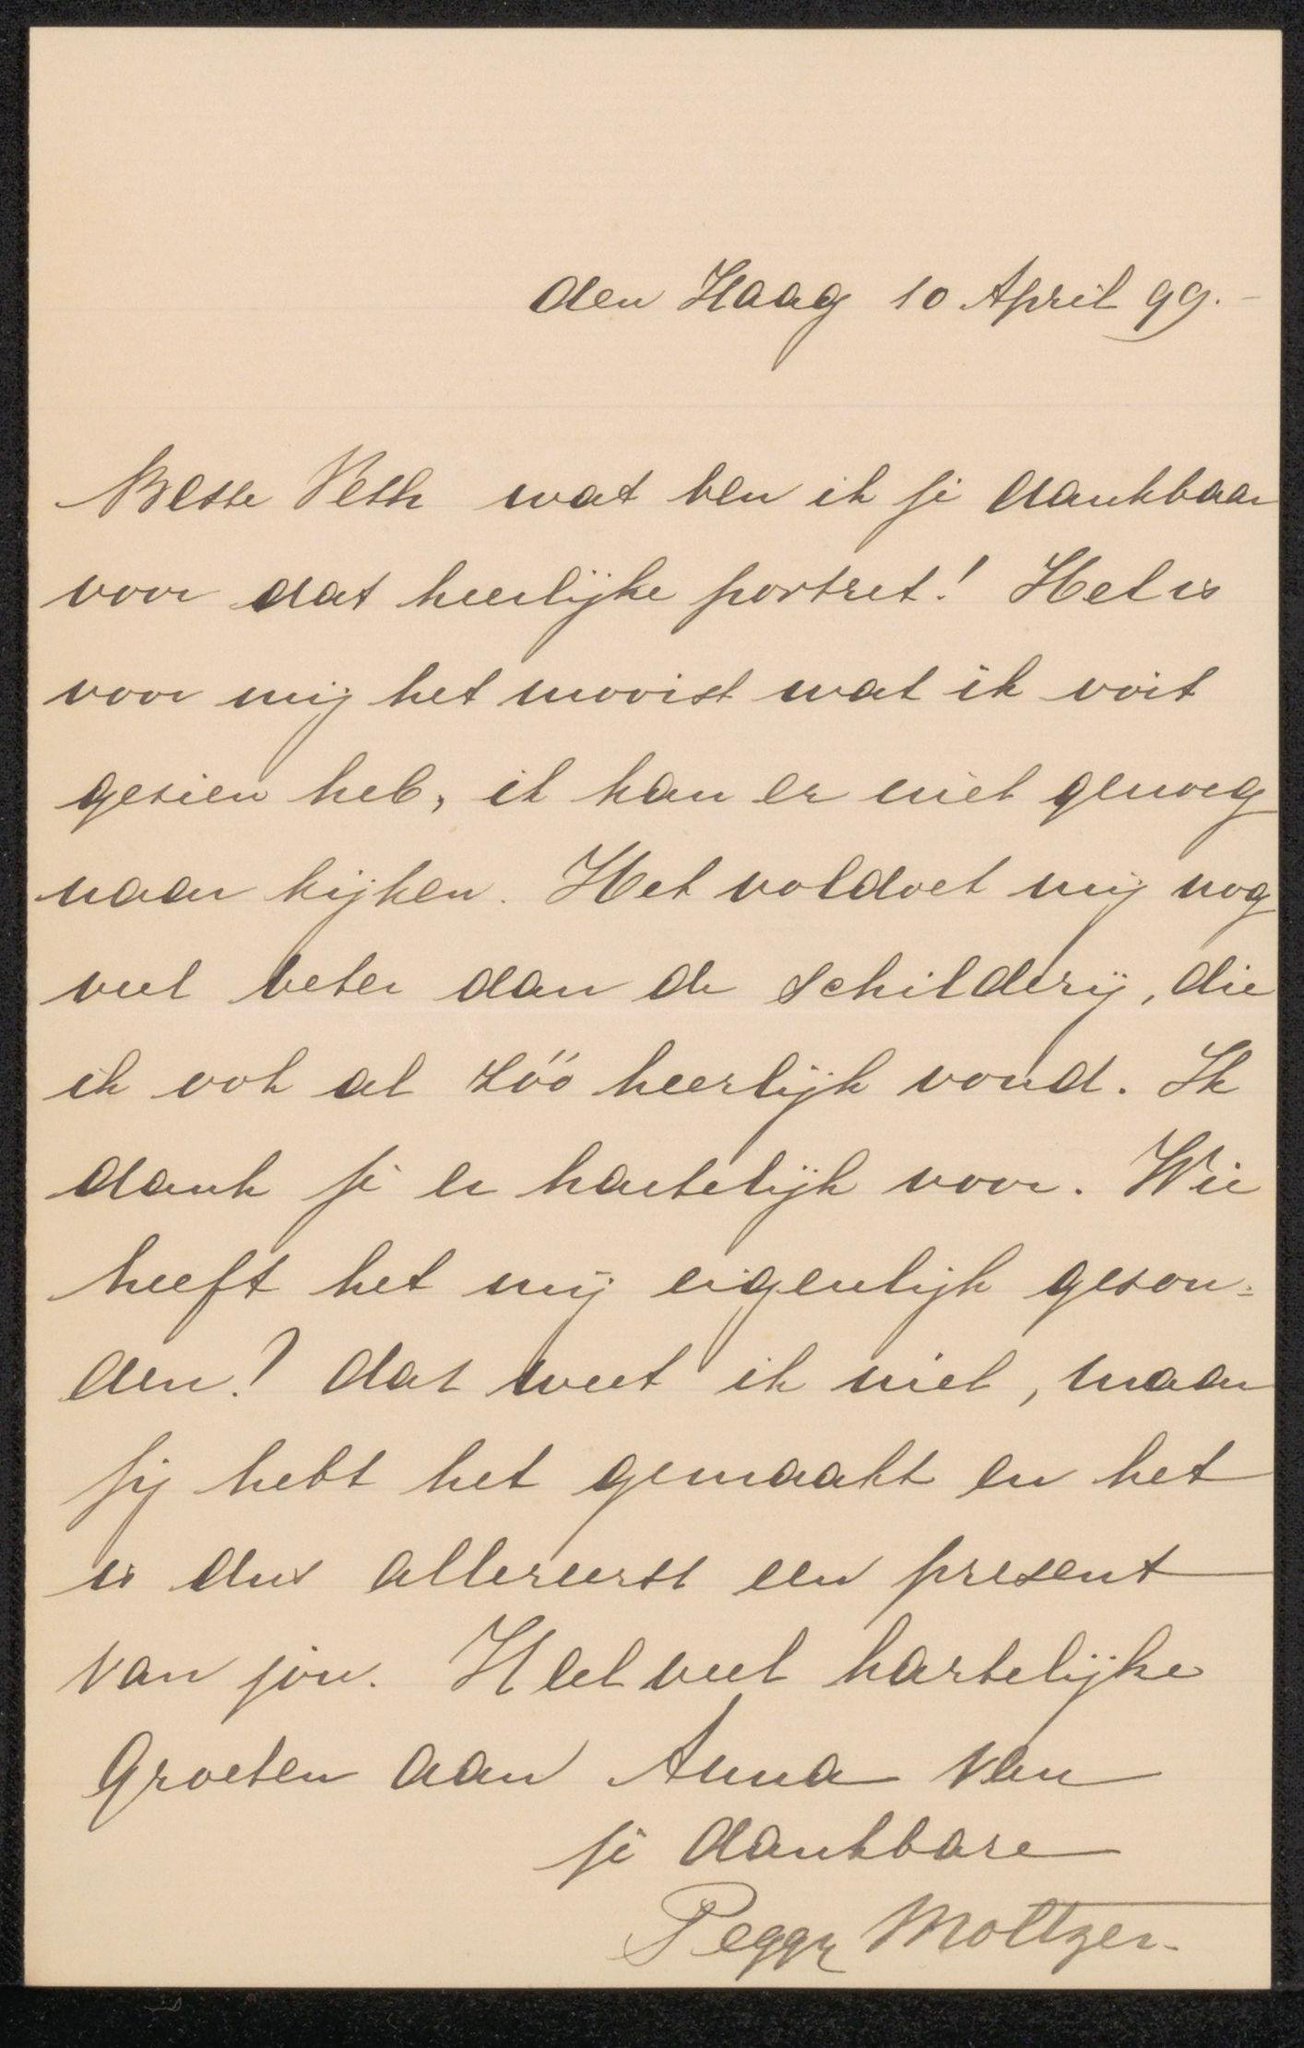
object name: letter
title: Brief aan Jan Veth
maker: peggy nicoline kappeyne van de coppello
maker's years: 1851-1924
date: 1899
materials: ink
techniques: pen, writing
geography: the hague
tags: dordrecht, amsterdam, painter, print maker, draughtsman, designer, jan veth, painting (including book-illumination, miniature-painting), historical persons (portraits and scenes from the life)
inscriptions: watermark, collector's mark: ‘RPK’